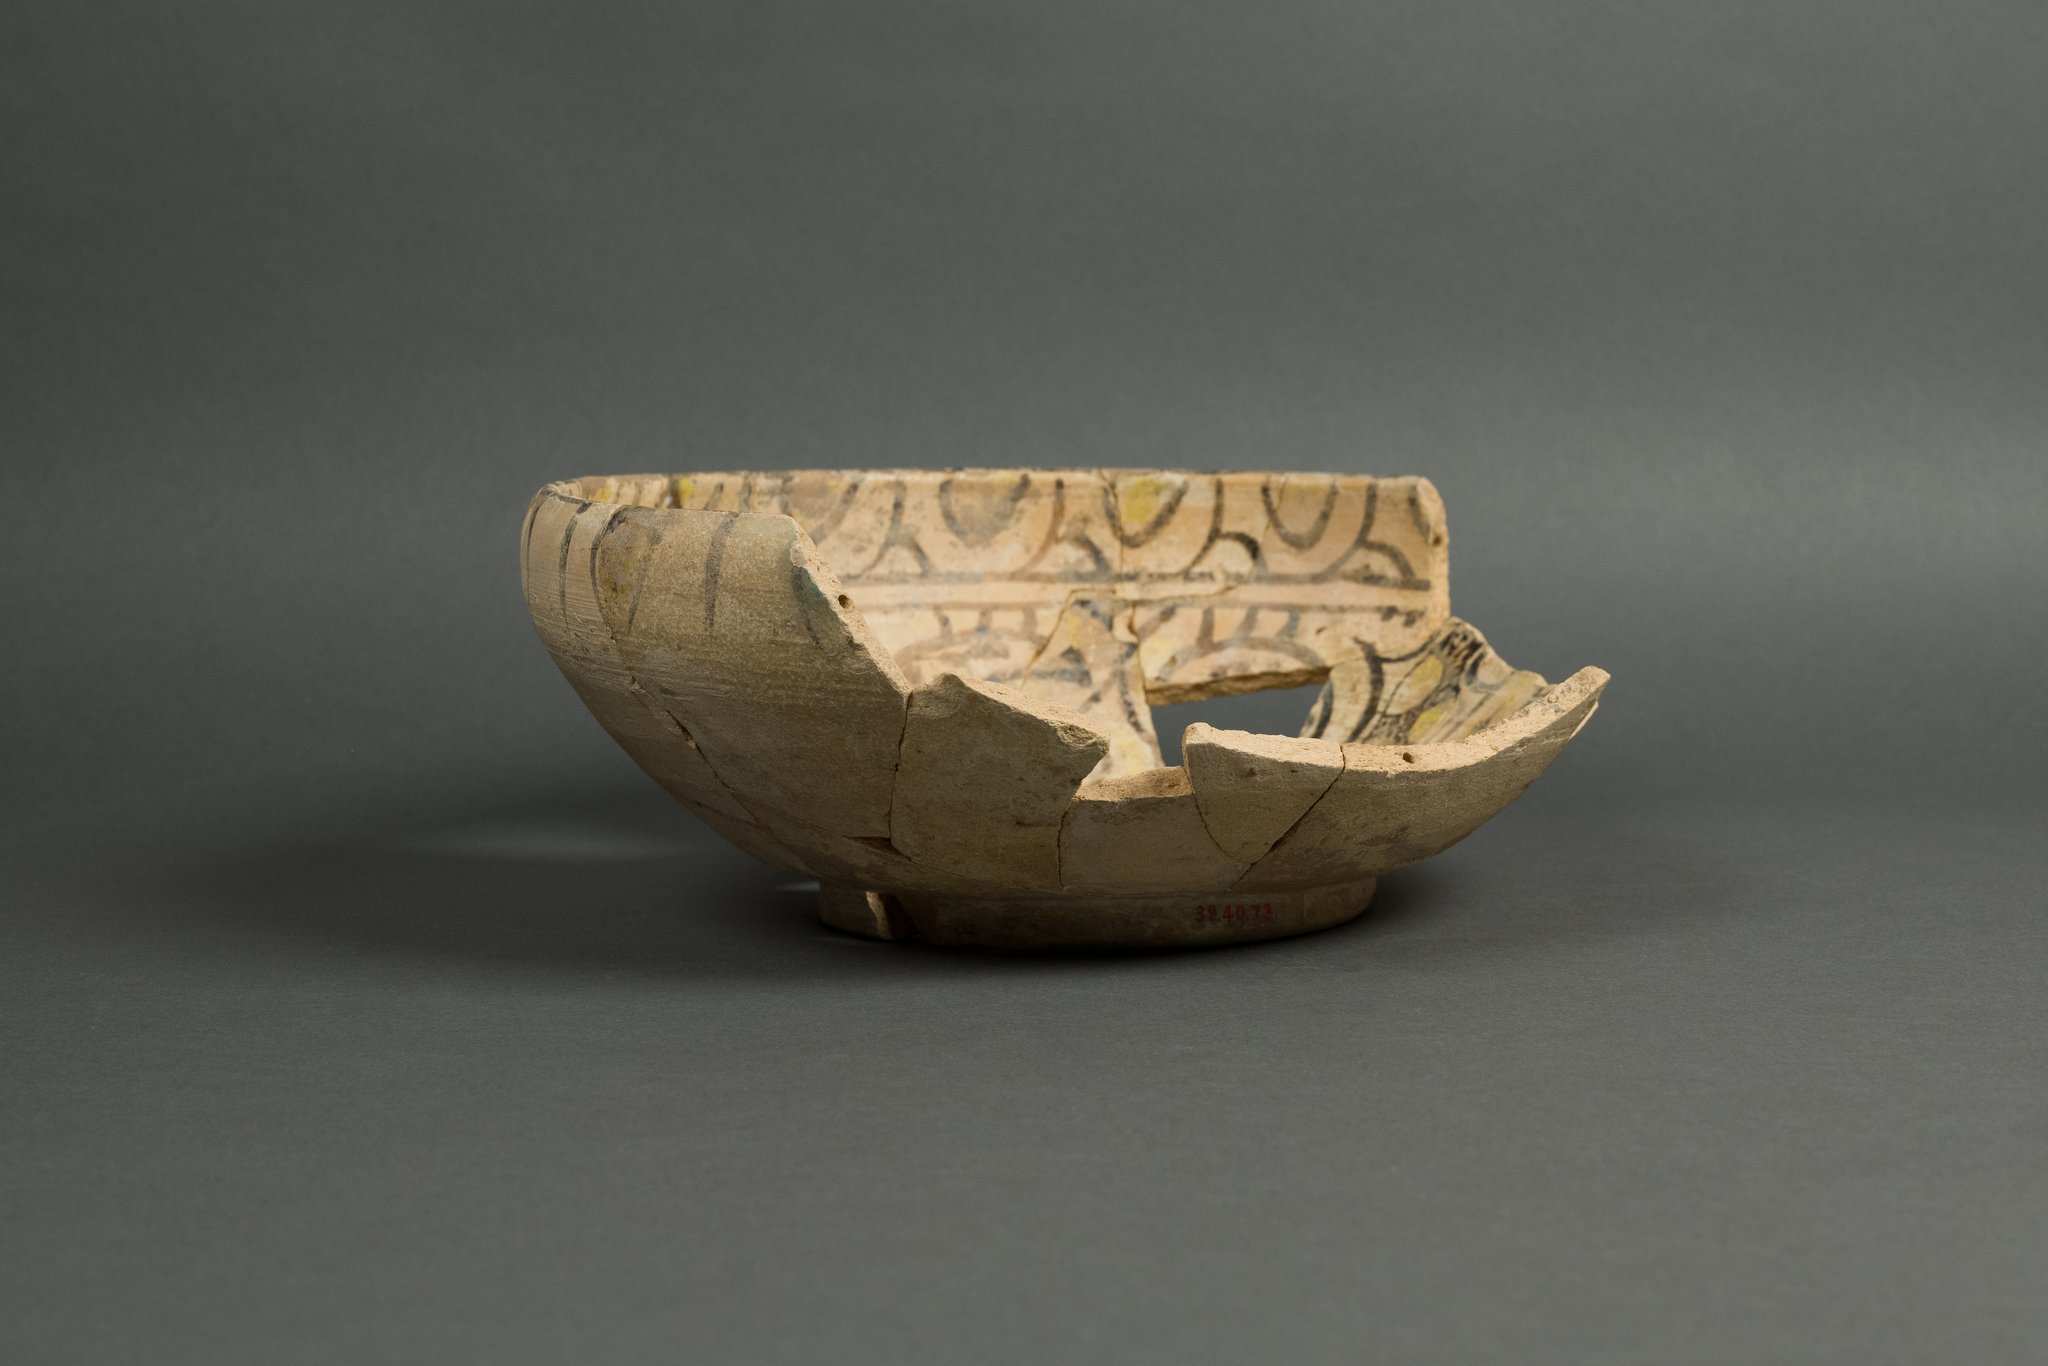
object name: bowl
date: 801-1000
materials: earthenware, glaze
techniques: polychrome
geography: iran